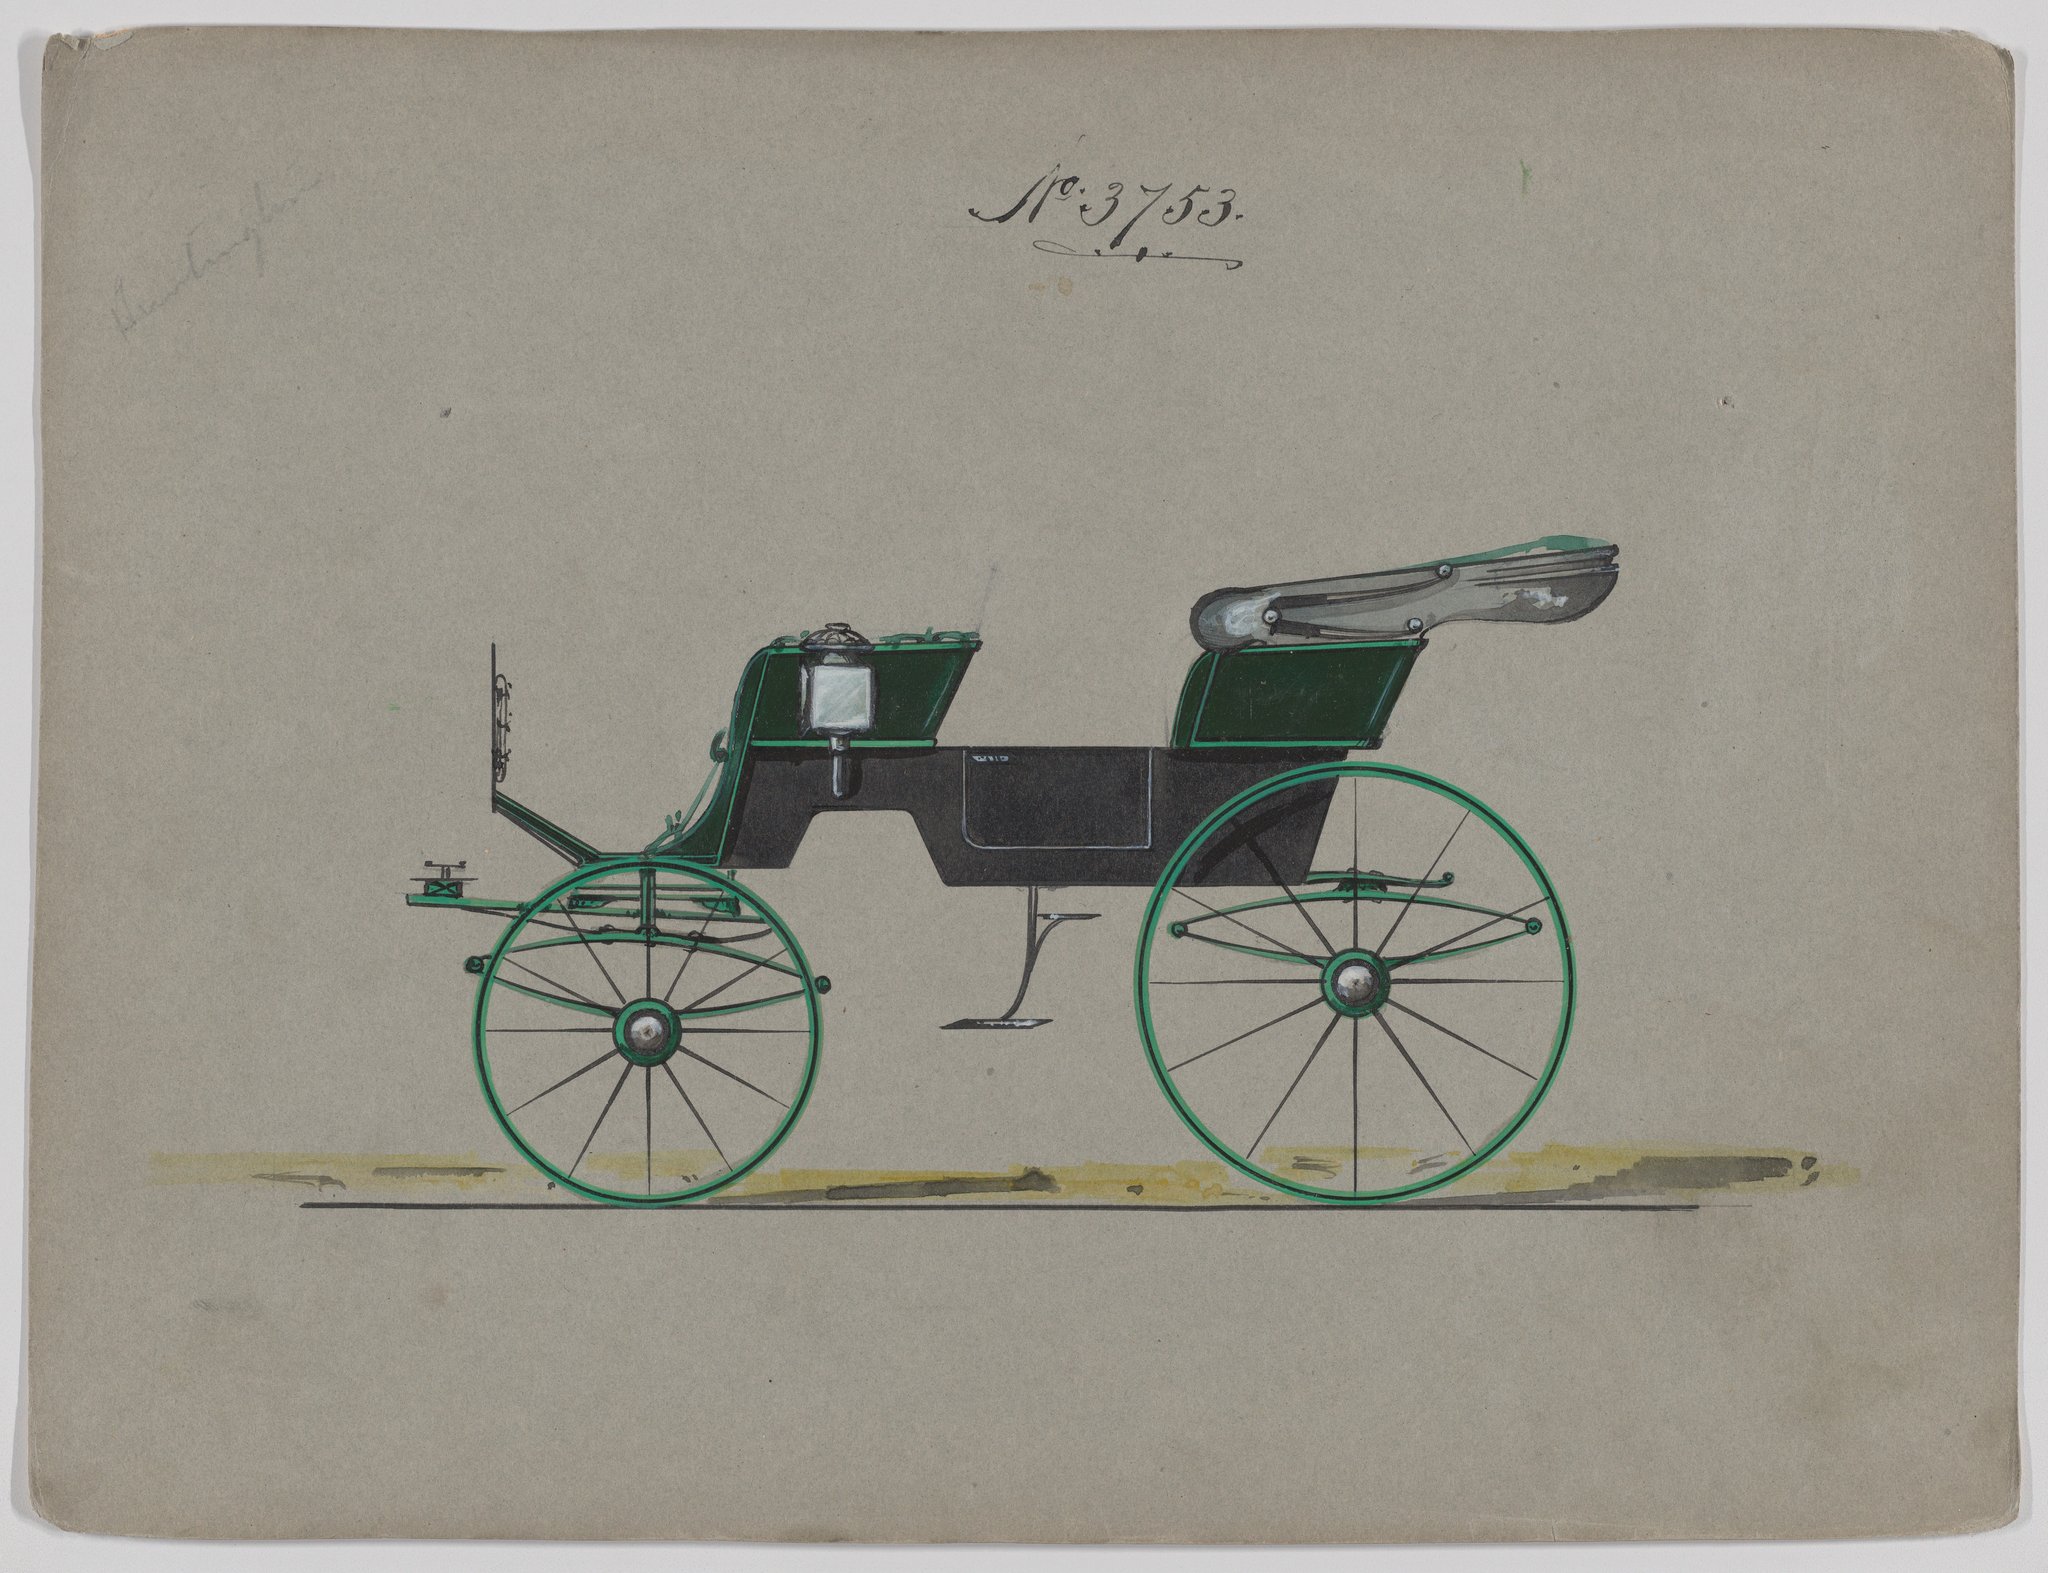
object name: drawing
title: Design for Phaeton, no. 3753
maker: brewster & co.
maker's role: manufacturer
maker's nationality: american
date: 1882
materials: gouache, ink, watercolor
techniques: pen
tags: carriages